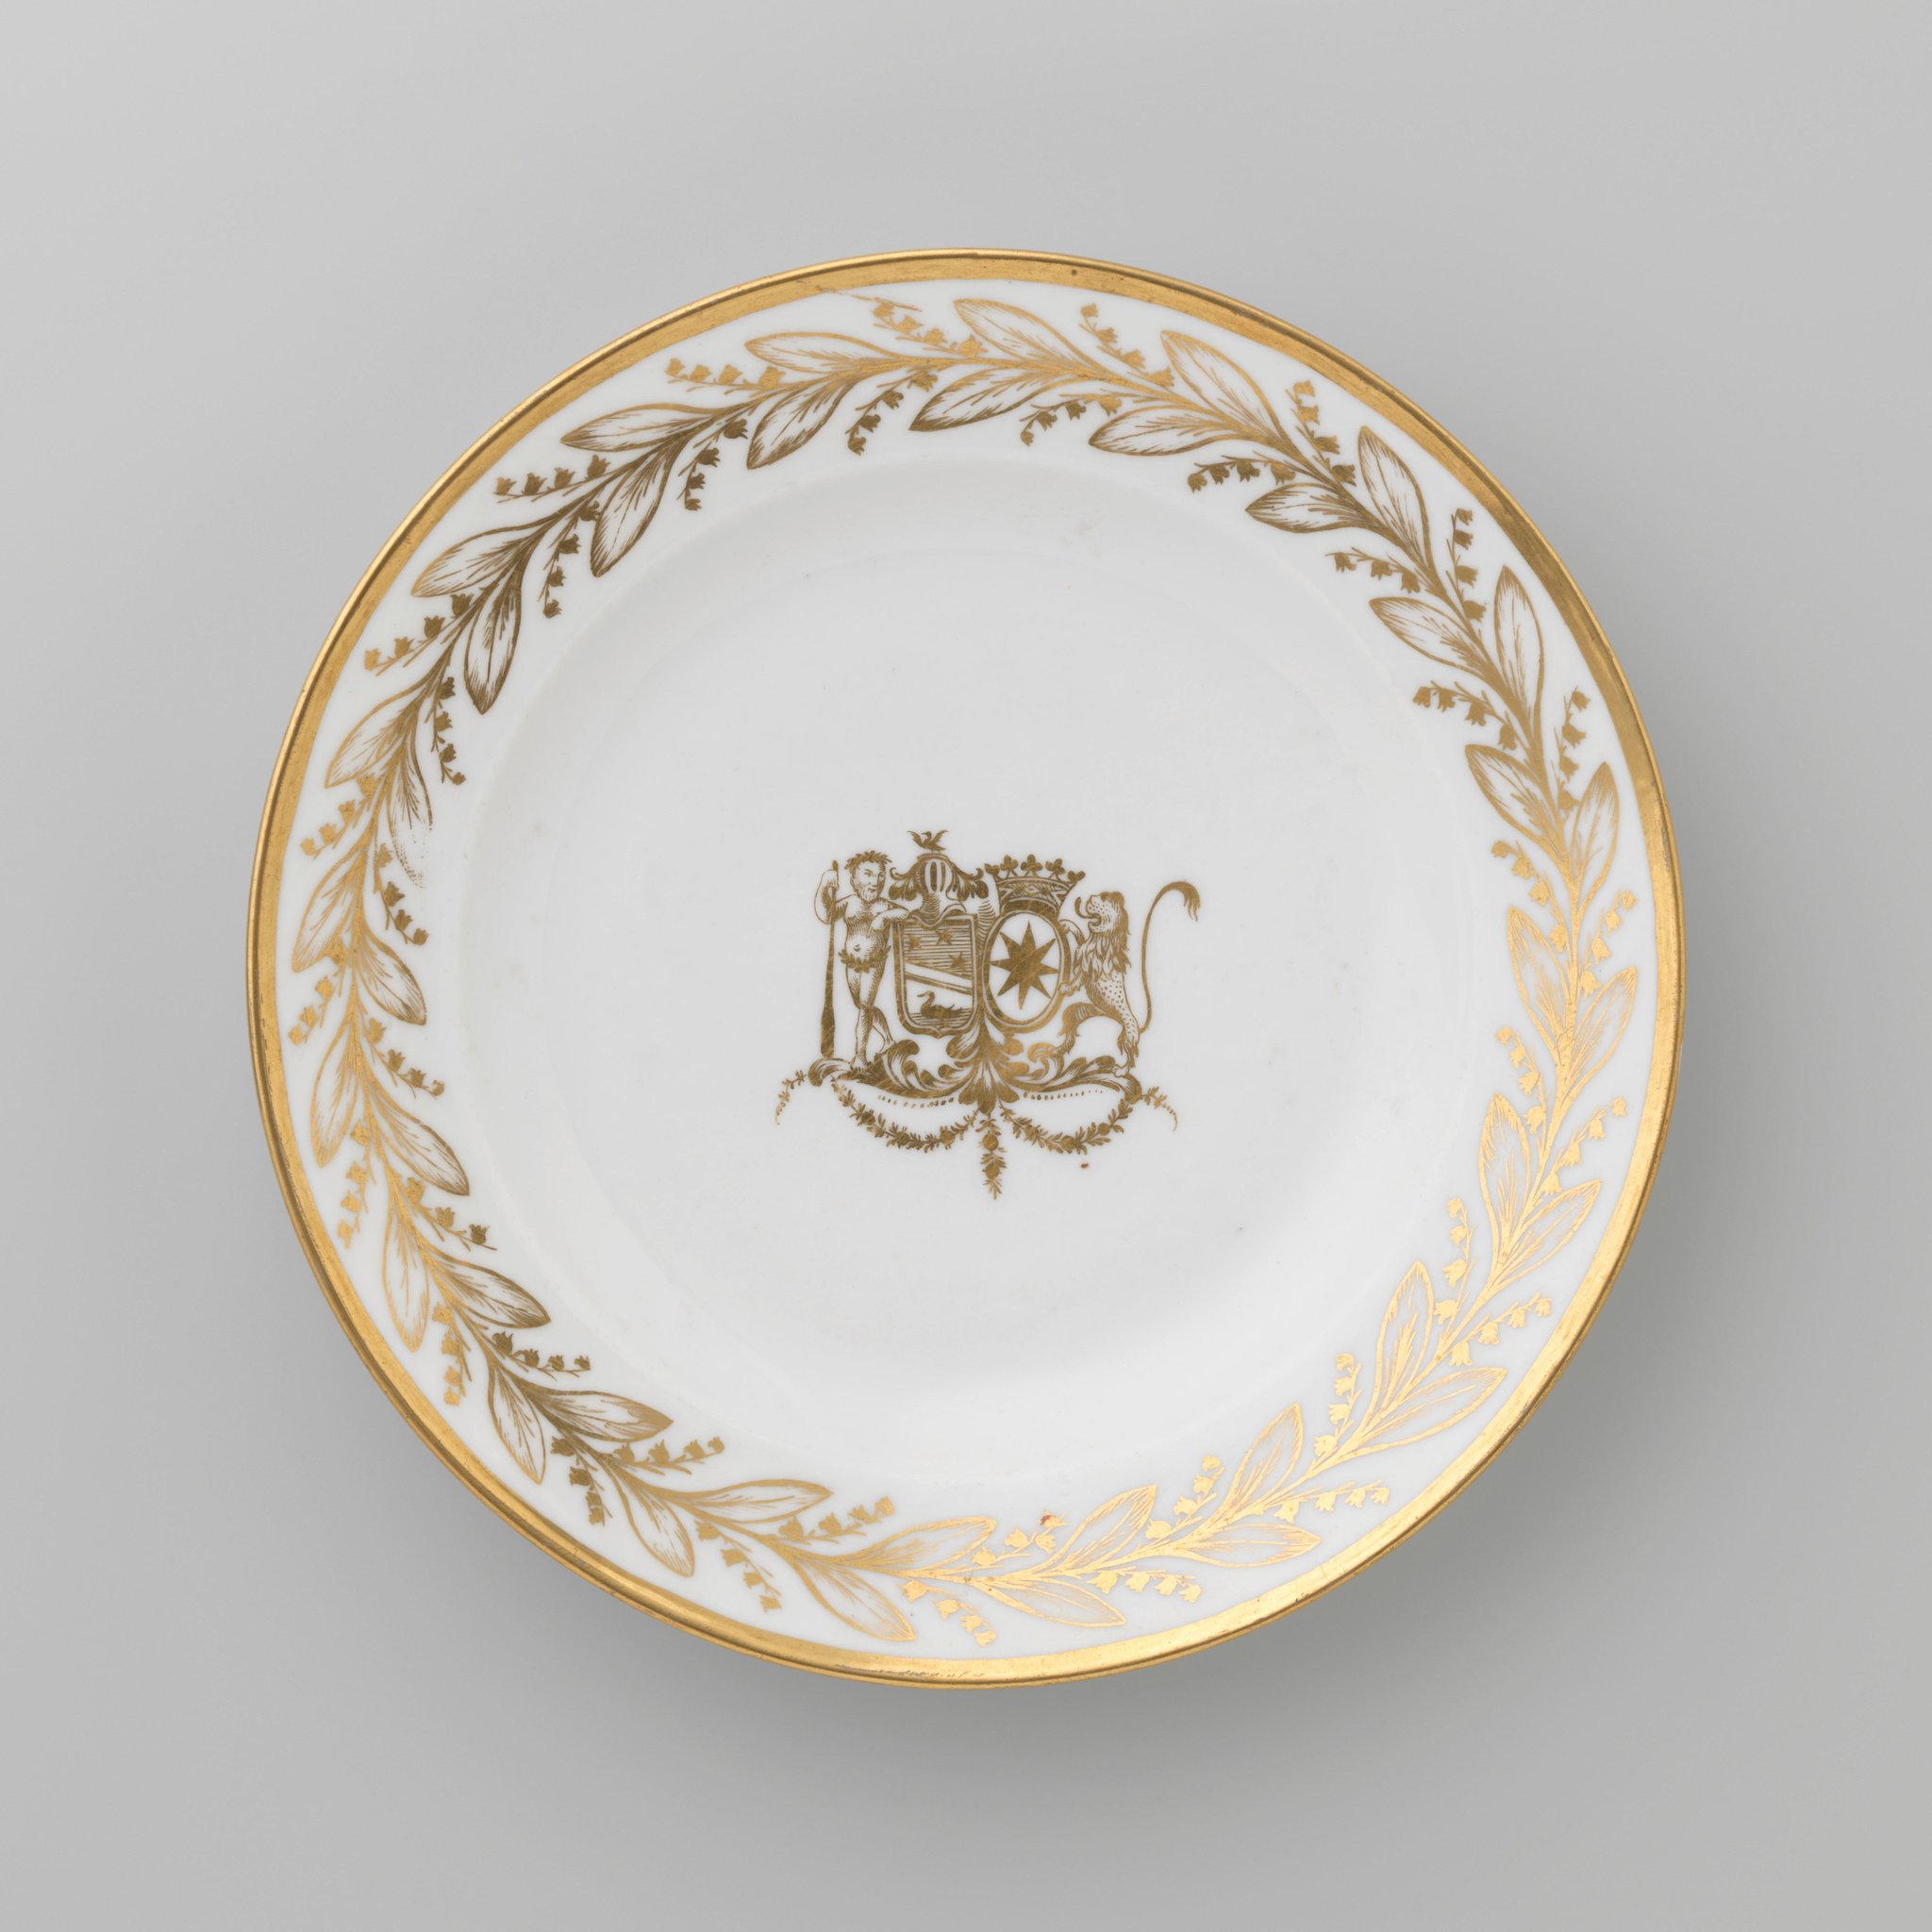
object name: service set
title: Dish with the coat of arms of Hendrik Peter Godfried Quack and Isabella Gertraud von Carnap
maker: Anonymous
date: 1790-1800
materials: glaze, gold, paint, porcelain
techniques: firing, forming, gilding, turning, vitrification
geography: paris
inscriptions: mark: ‘N/ 5’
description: Schotel, rond, van porselein, behorend bij een servies met versiering in goud van een bloem- en bladkrans en met het alliantiewapen van Hendrik Peter Godfried Quack en Isabella Gertraud von Carnap. Gemerkt met ingegrifte letter N en de letter 5. Opmerking: schotel vermoedelijke 19de eeuws.